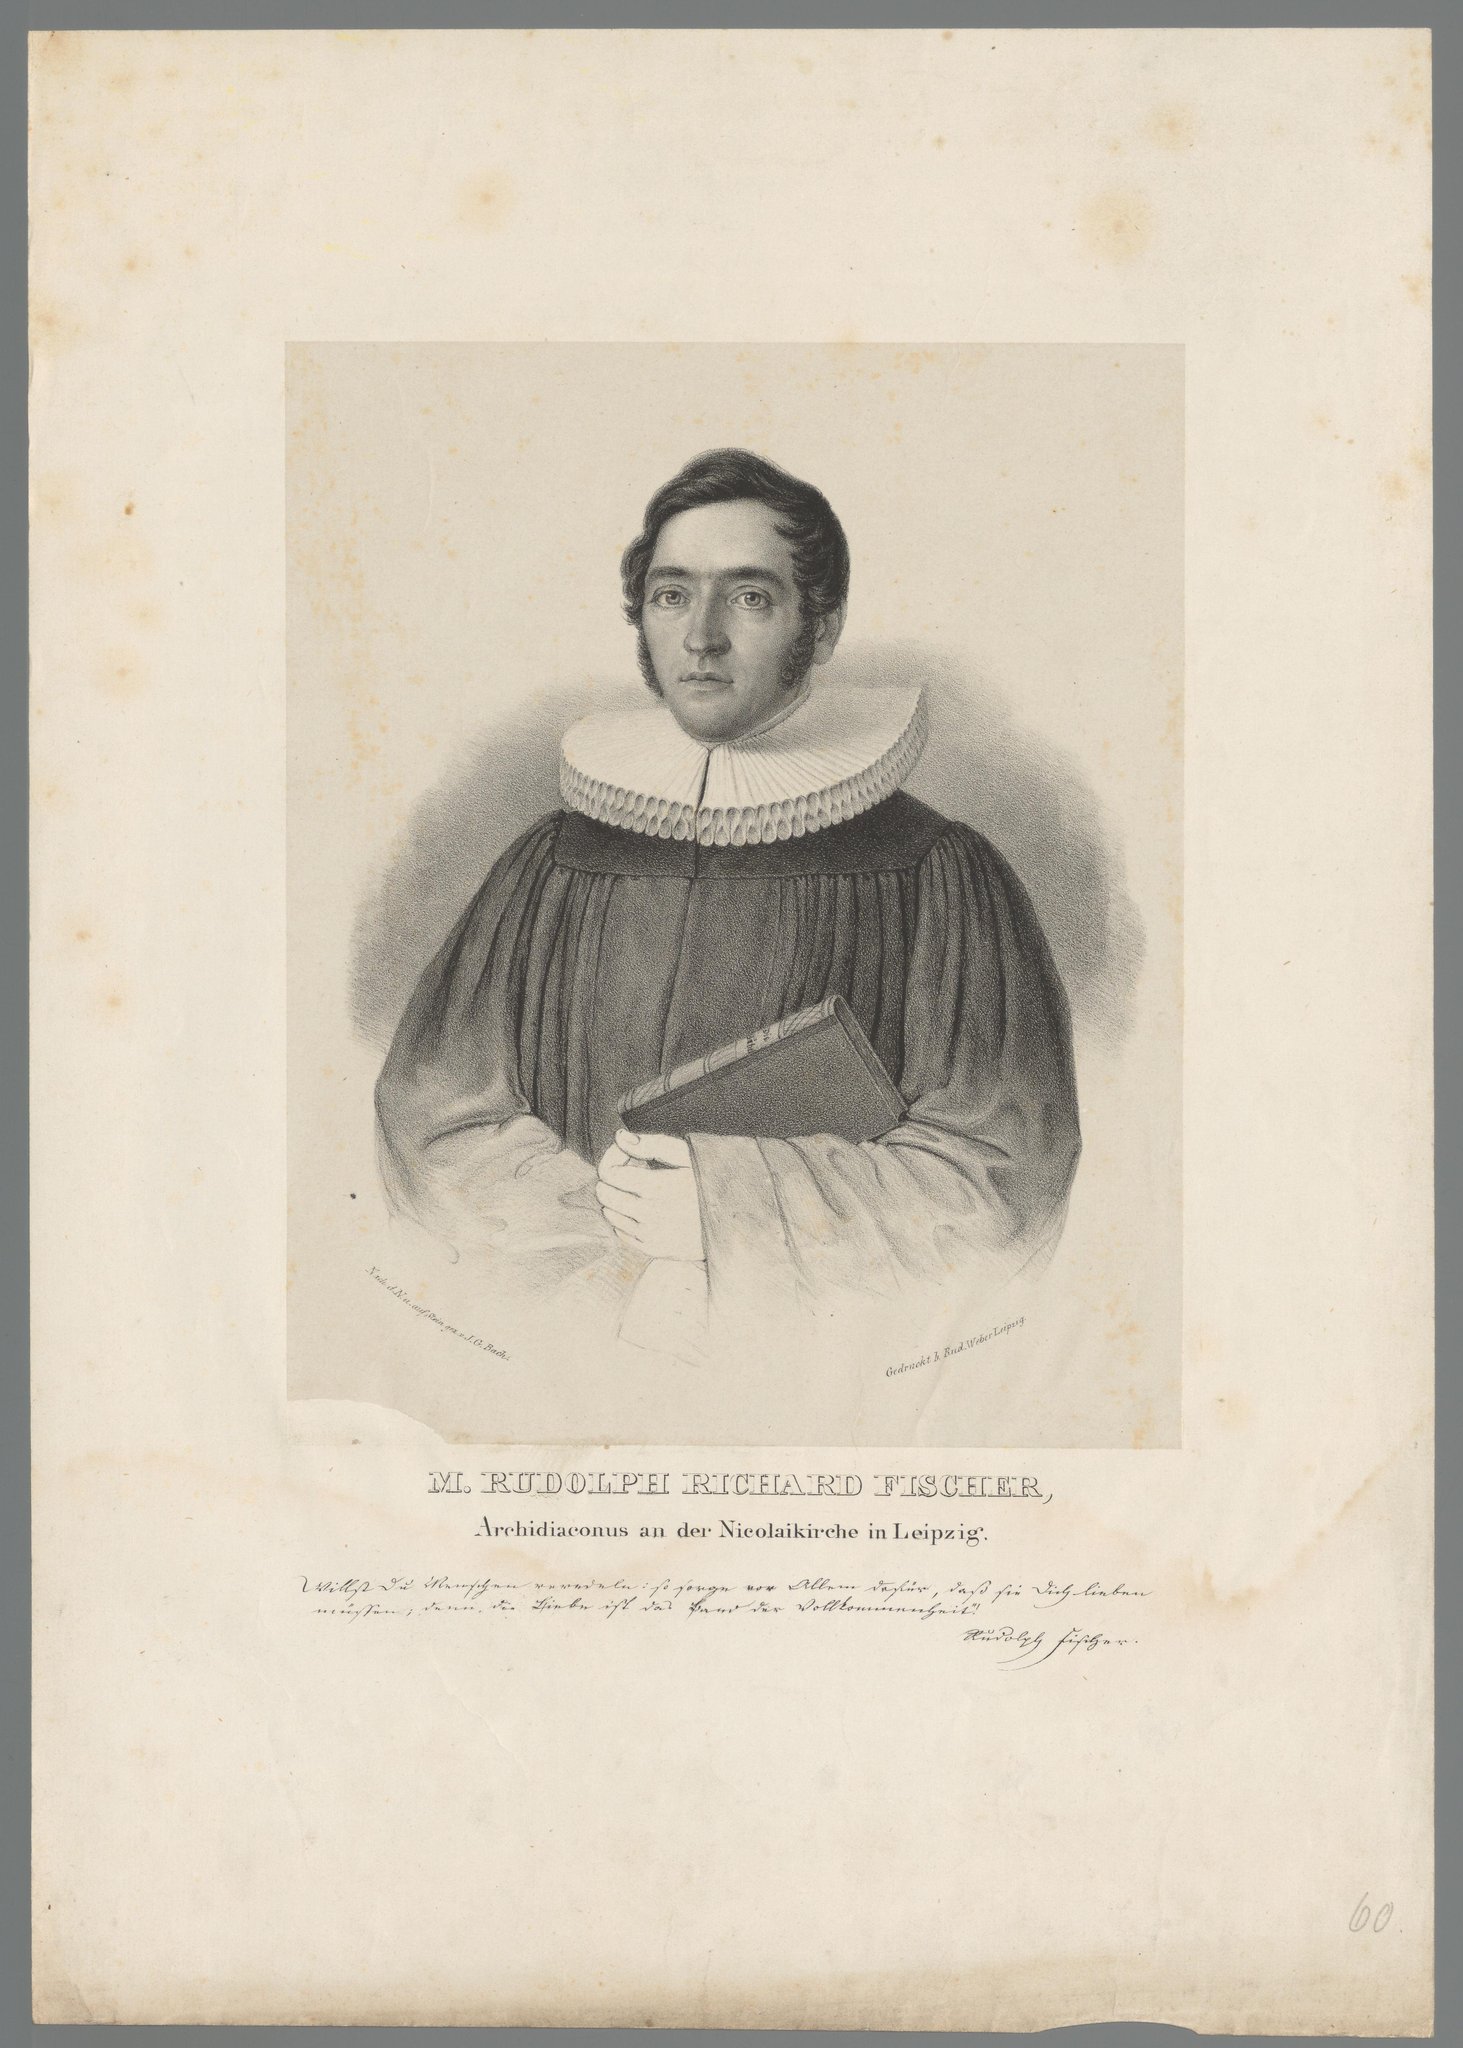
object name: print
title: M. Rudolph Richard Fischer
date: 1820-1880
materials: paper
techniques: lithograph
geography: leipzig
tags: adult man, historical persons, prelates, e.g. archdeacon, canon (roman catholic)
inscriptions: collector's mark: Lugt 2228